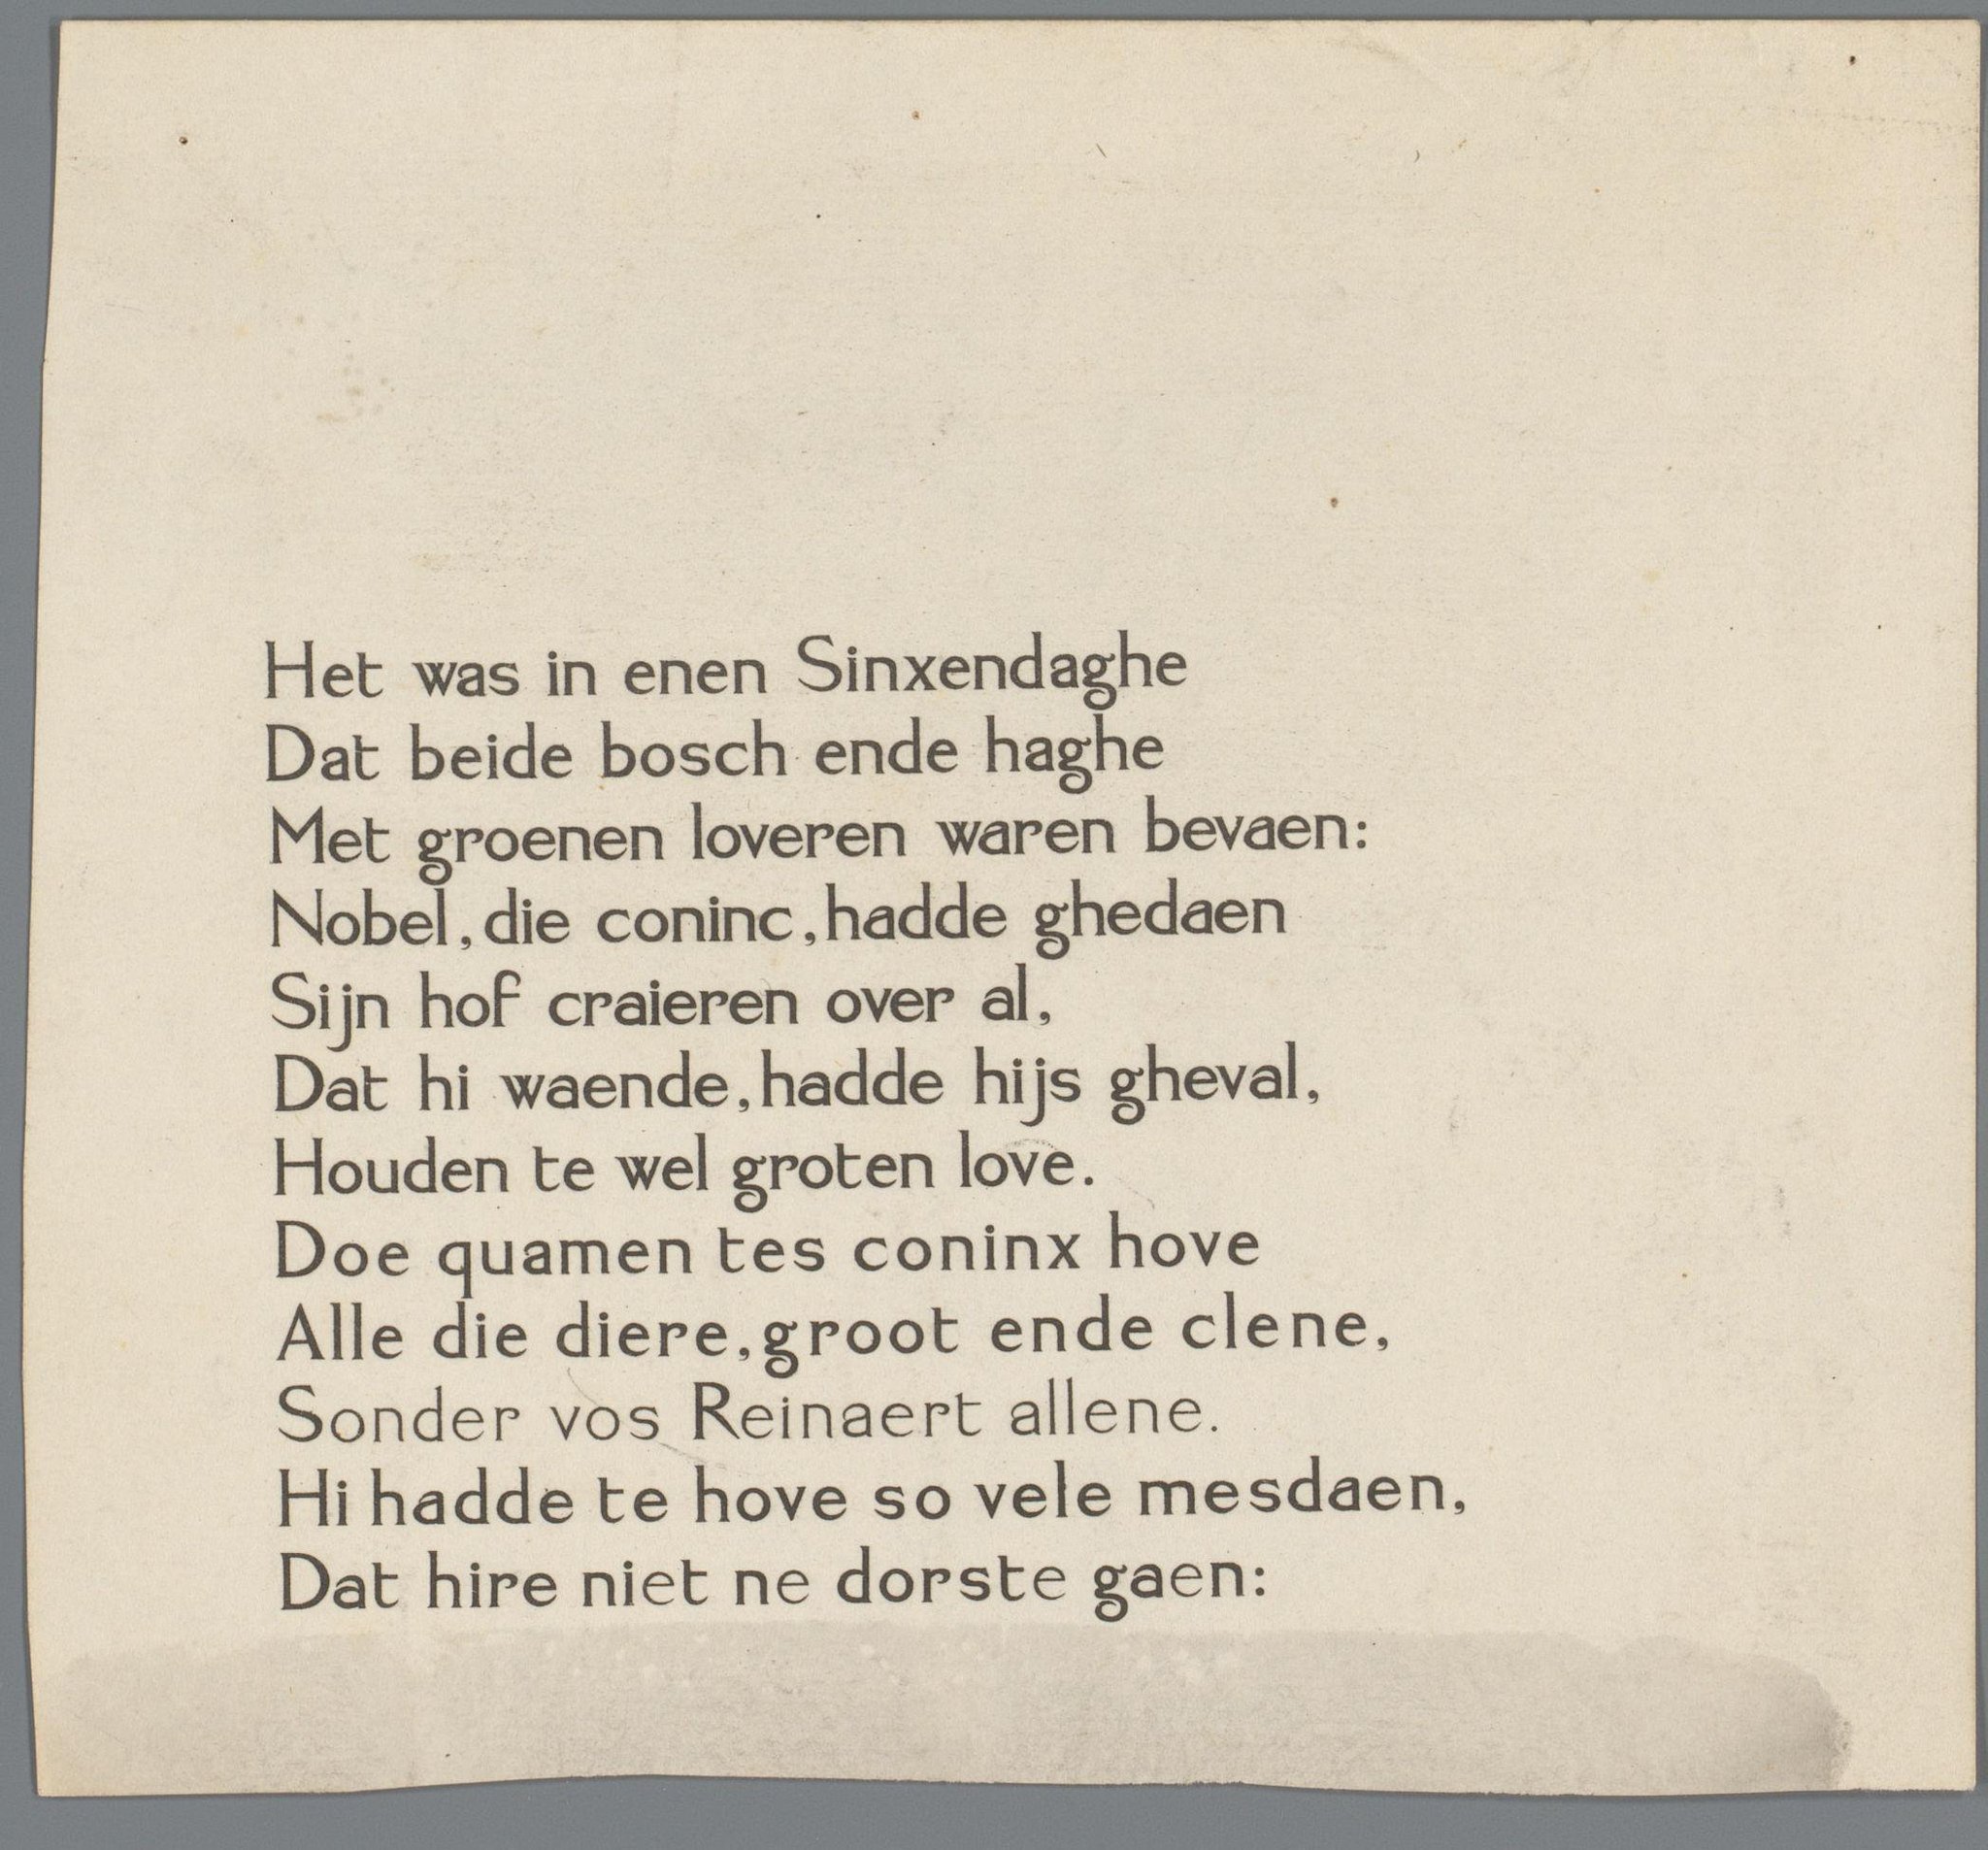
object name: text sheet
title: Proefdruk van twaalf regels van Van den vos Reynaerde in de Klei-type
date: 1896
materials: paper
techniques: photolithography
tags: printed matter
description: De hier weergegeven letter is fotolithografisch verkleind van het origineel dat door Gerrit Willem Dijsselhof in hout gesneden werd.